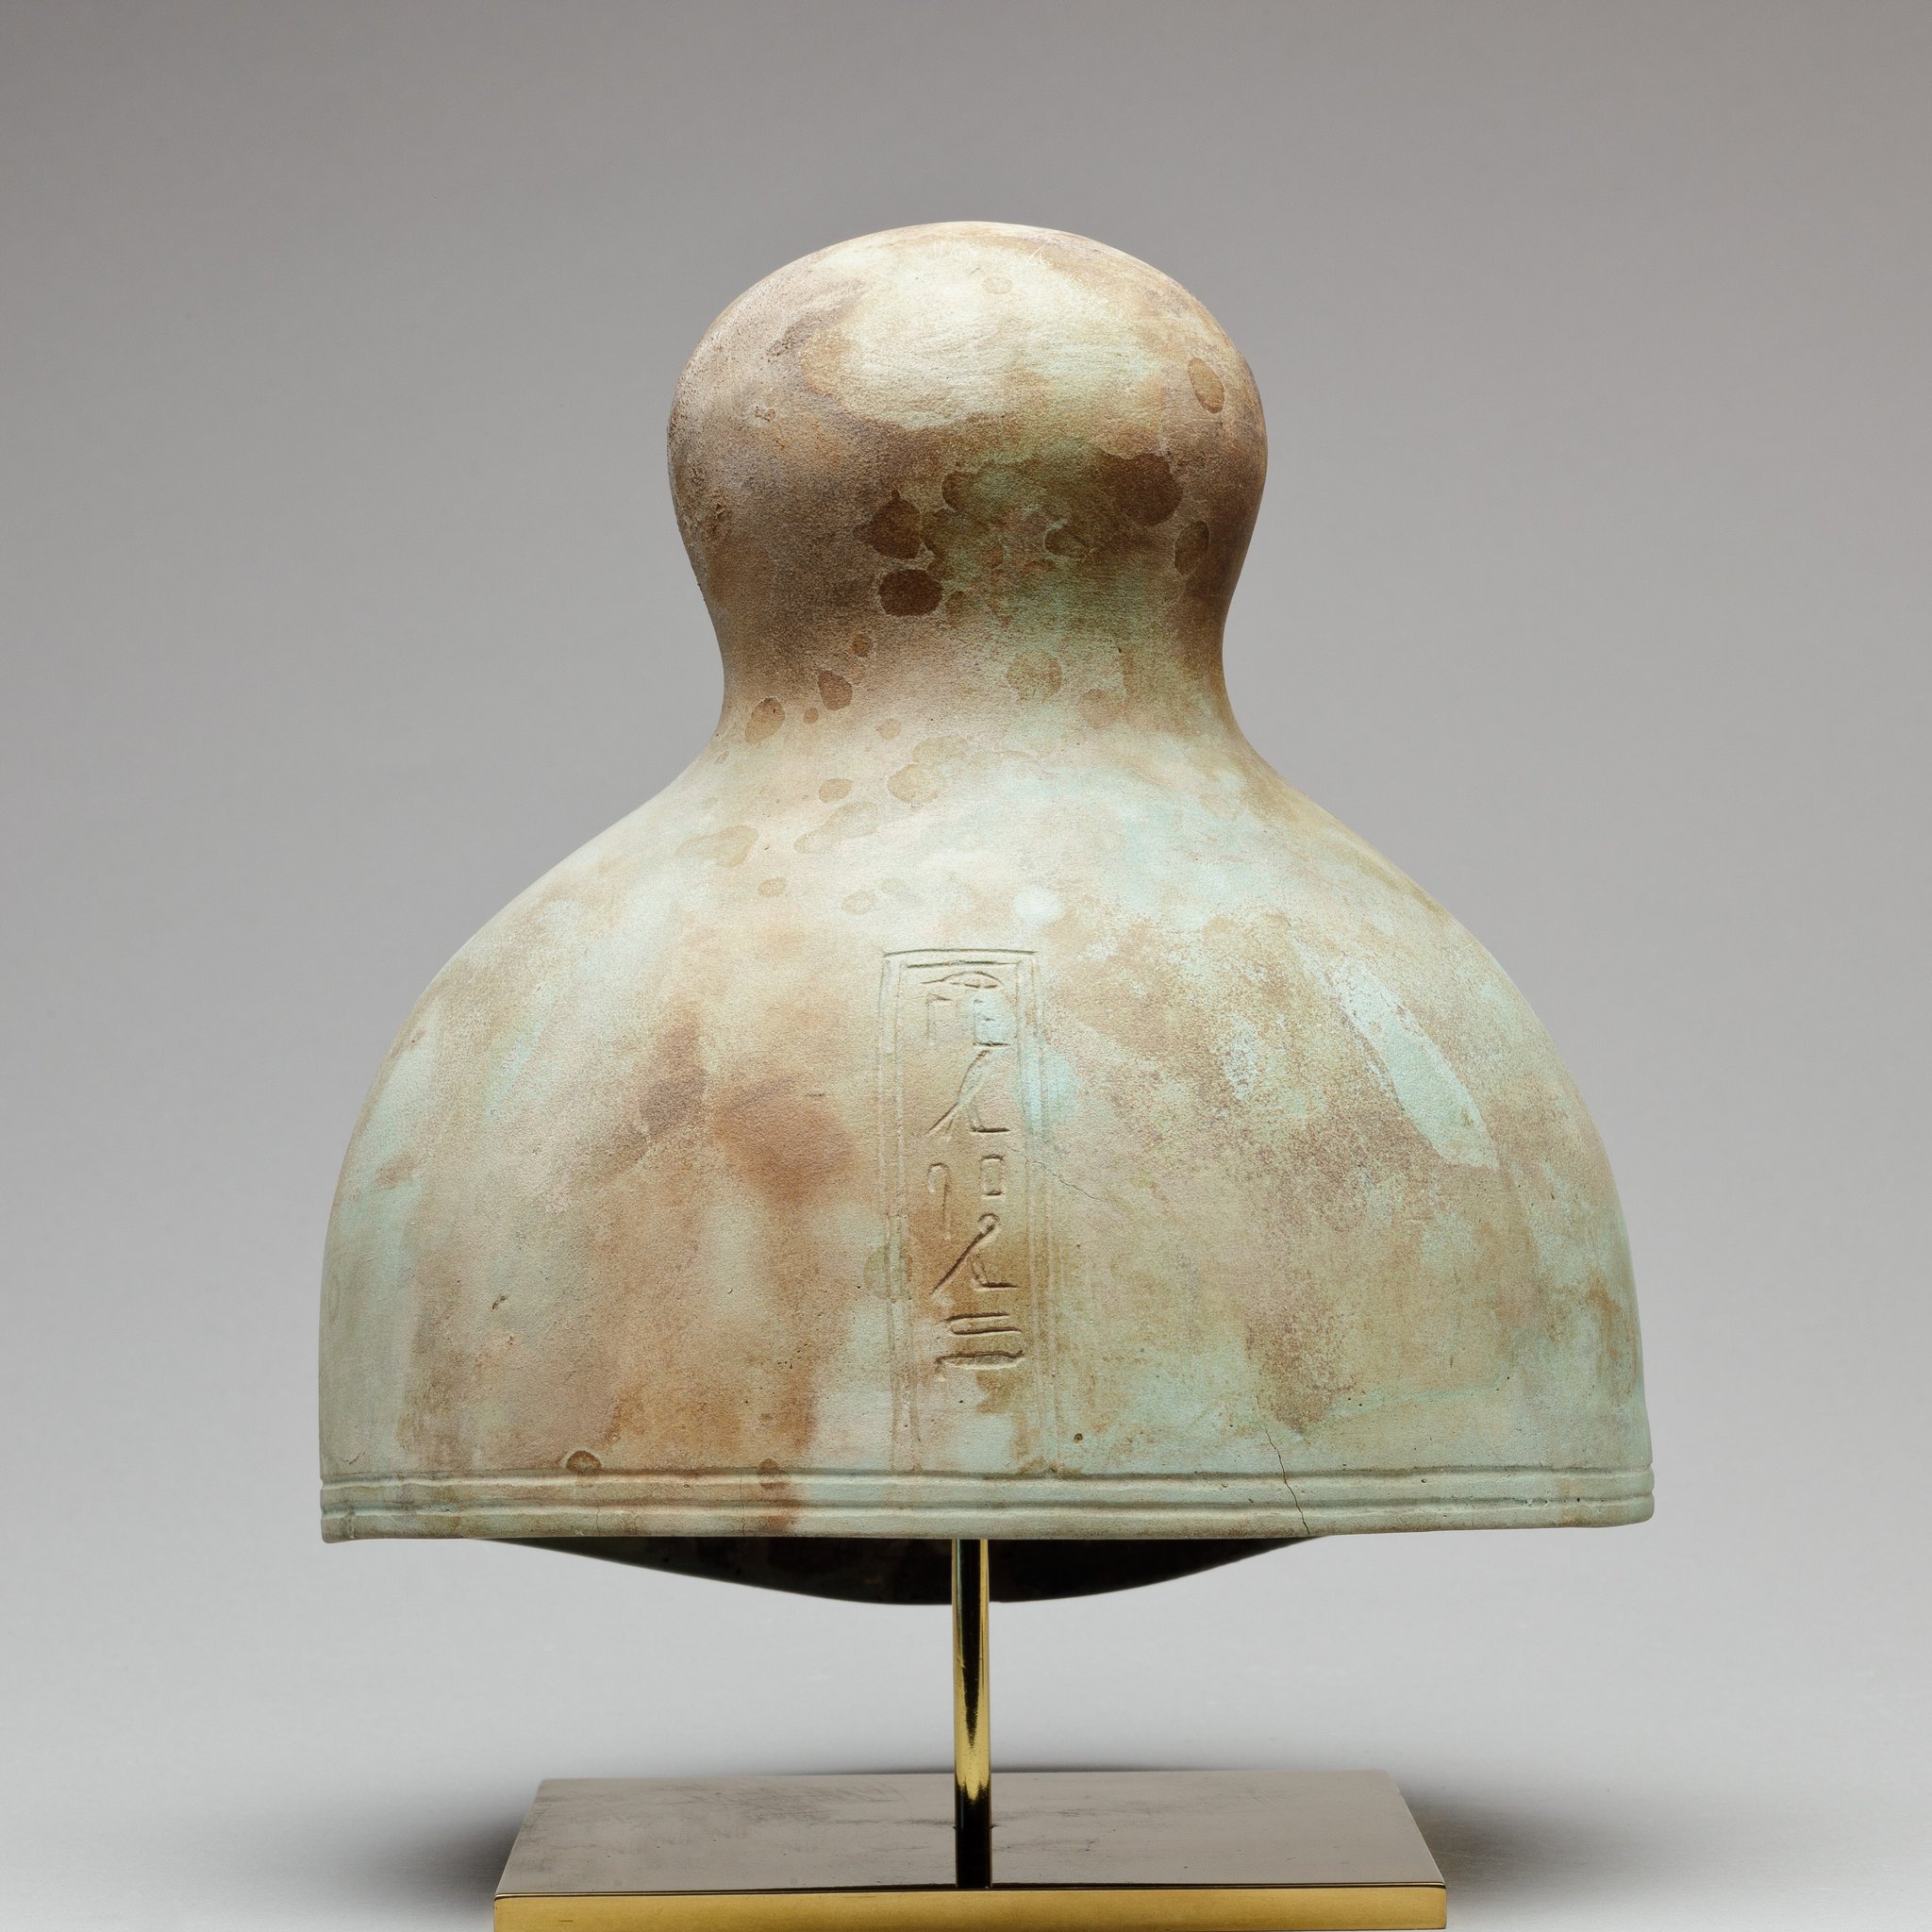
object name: helmet, ceremonial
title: Ceremonial helmet? / funerary crown? inscribed for the Osiris Hor-Psamtik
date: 664-525 BCE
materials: faience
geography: egypt